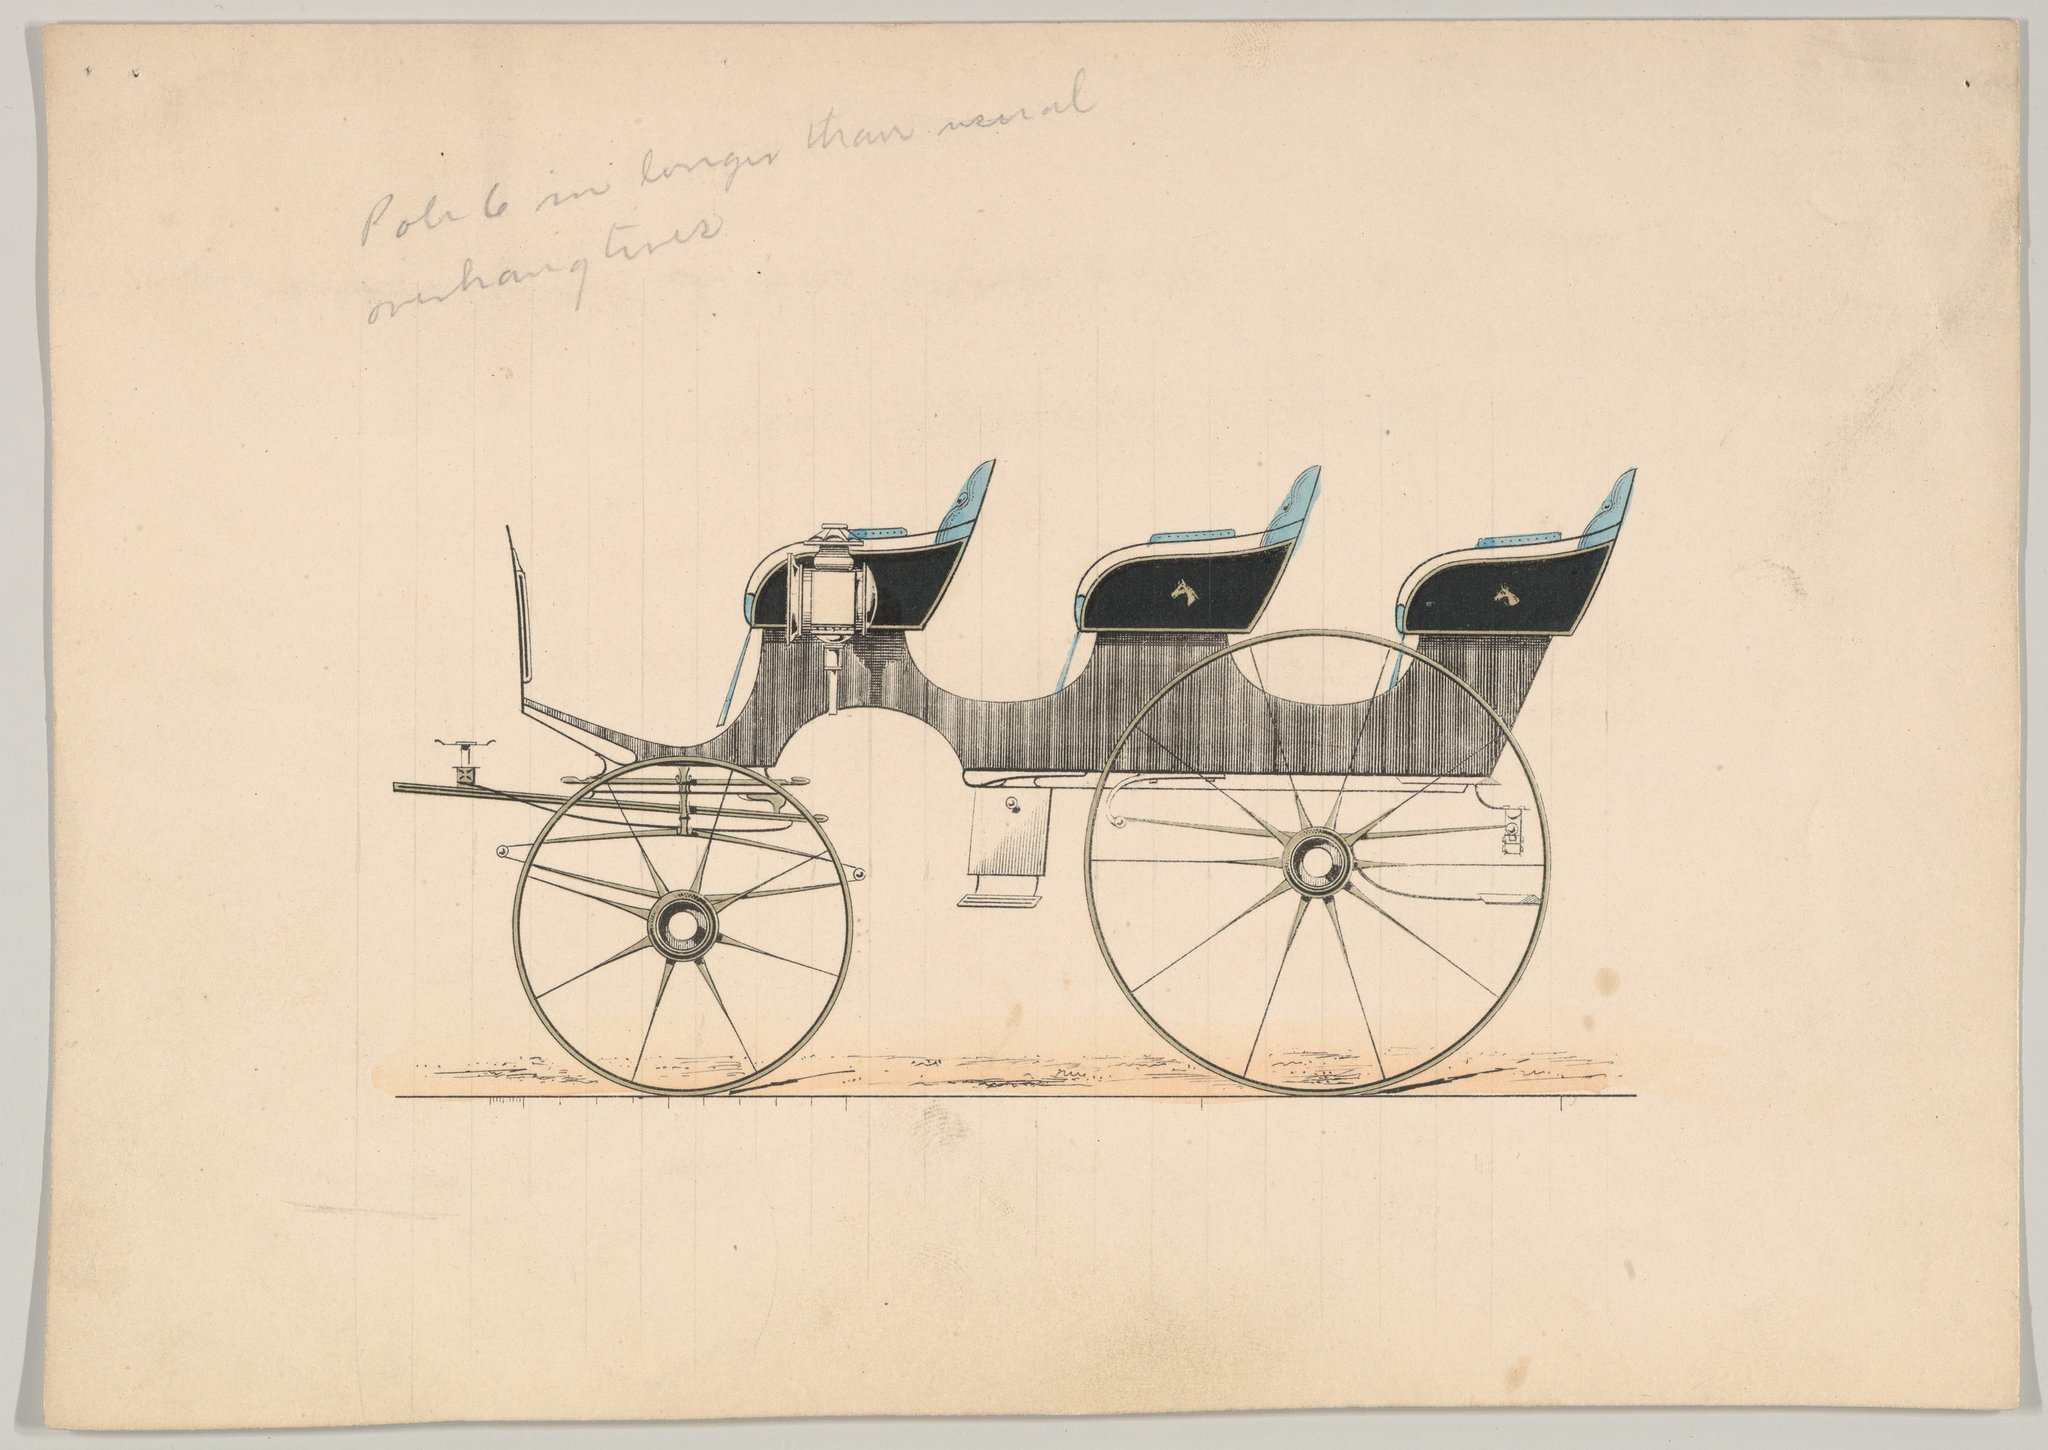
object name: print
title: Excursion Wagon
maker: brewster & co.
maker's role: manufacturer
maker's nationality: american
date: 1850-1870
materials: gum arabic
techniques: engraving, hand coloring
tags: carriages